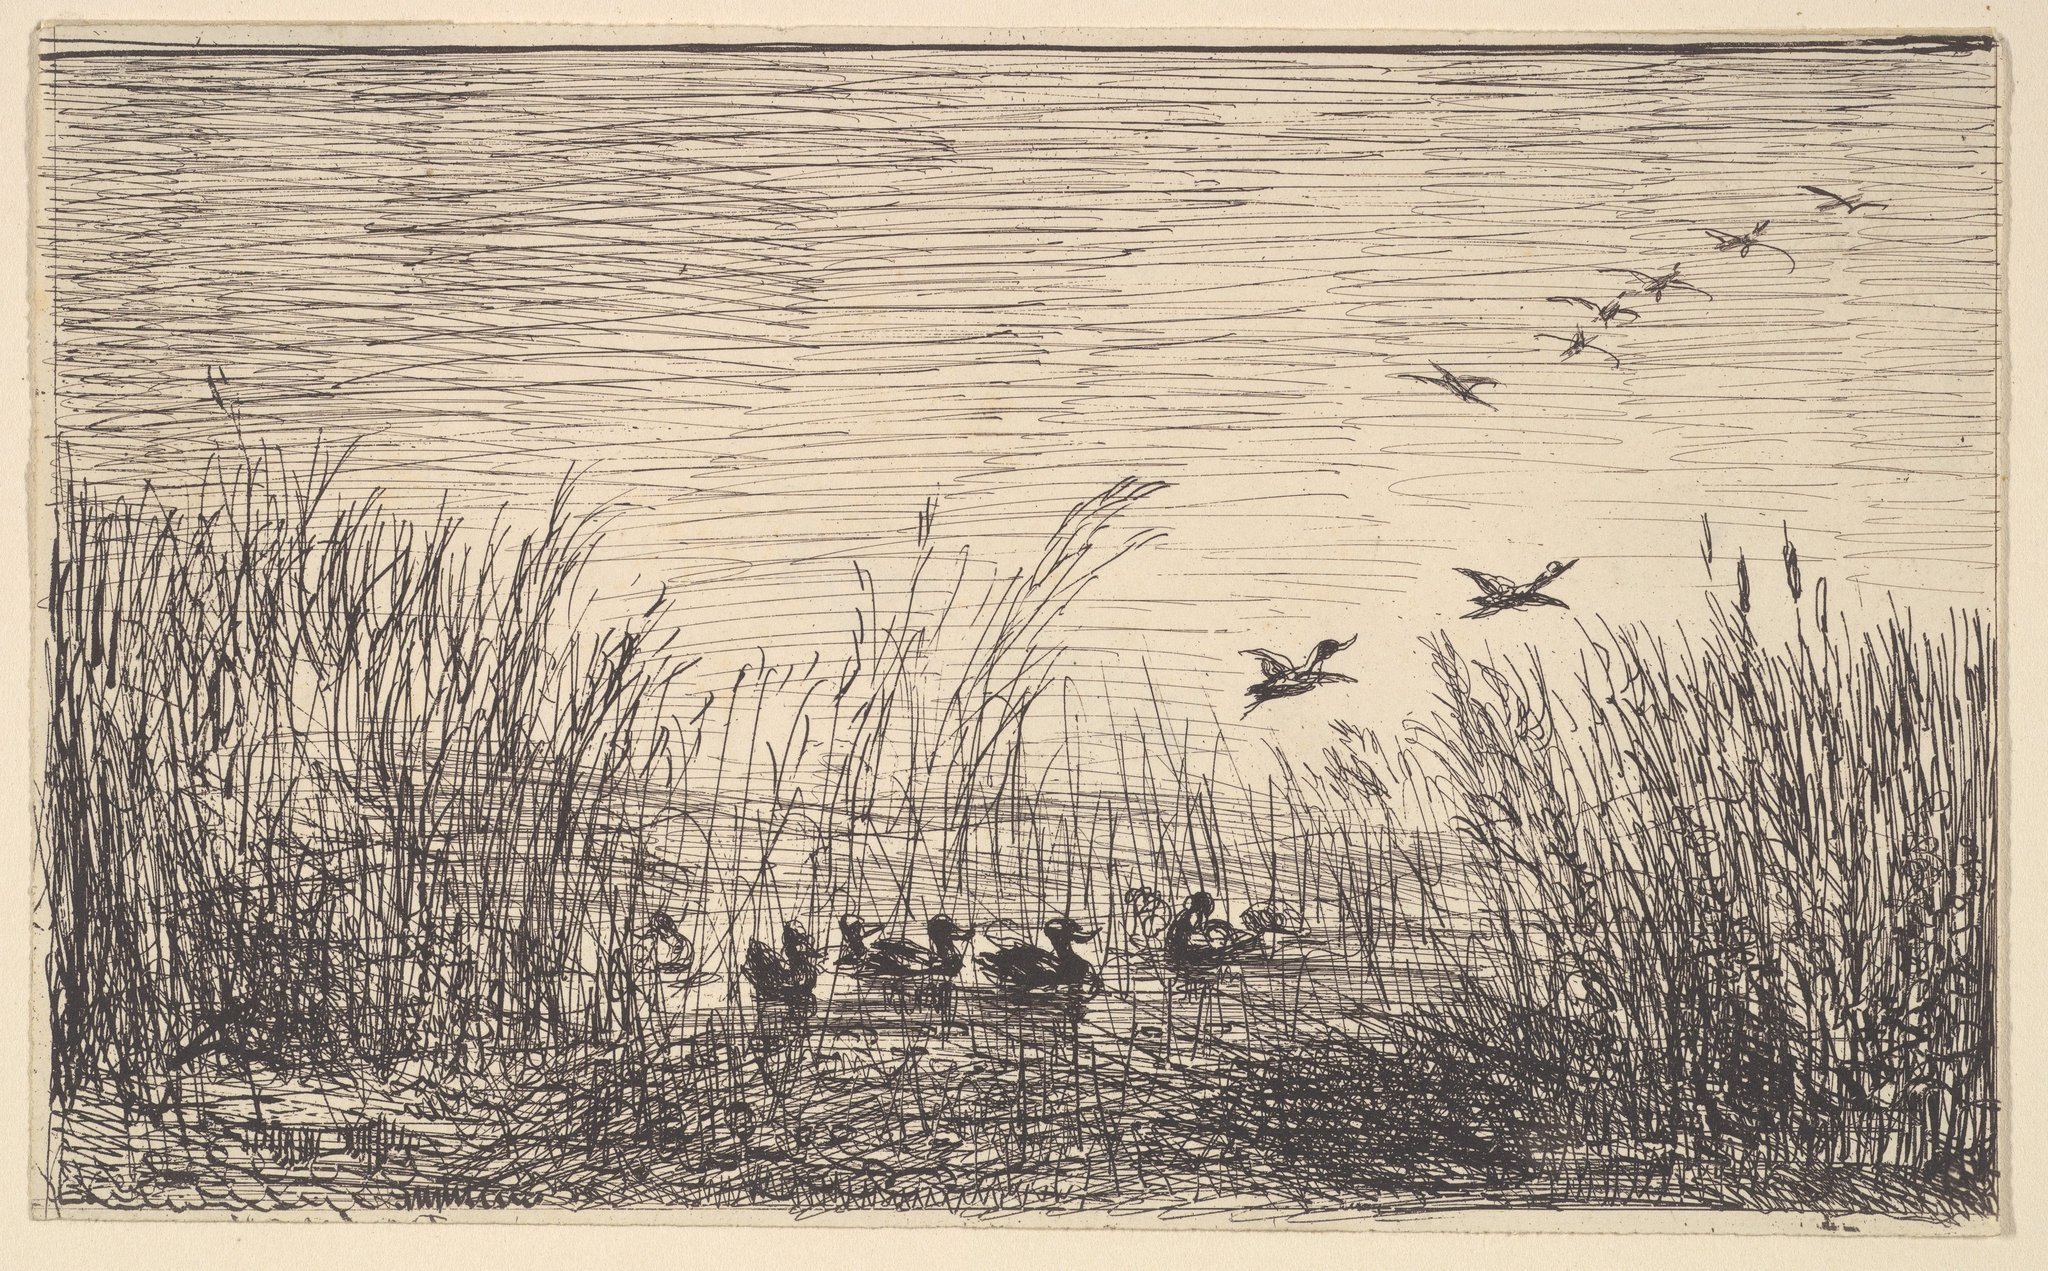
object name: print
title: Ducks in the Marshes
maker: charles-françois daubigny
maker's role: artist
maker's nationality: french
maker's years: 1817-1878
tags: ducks